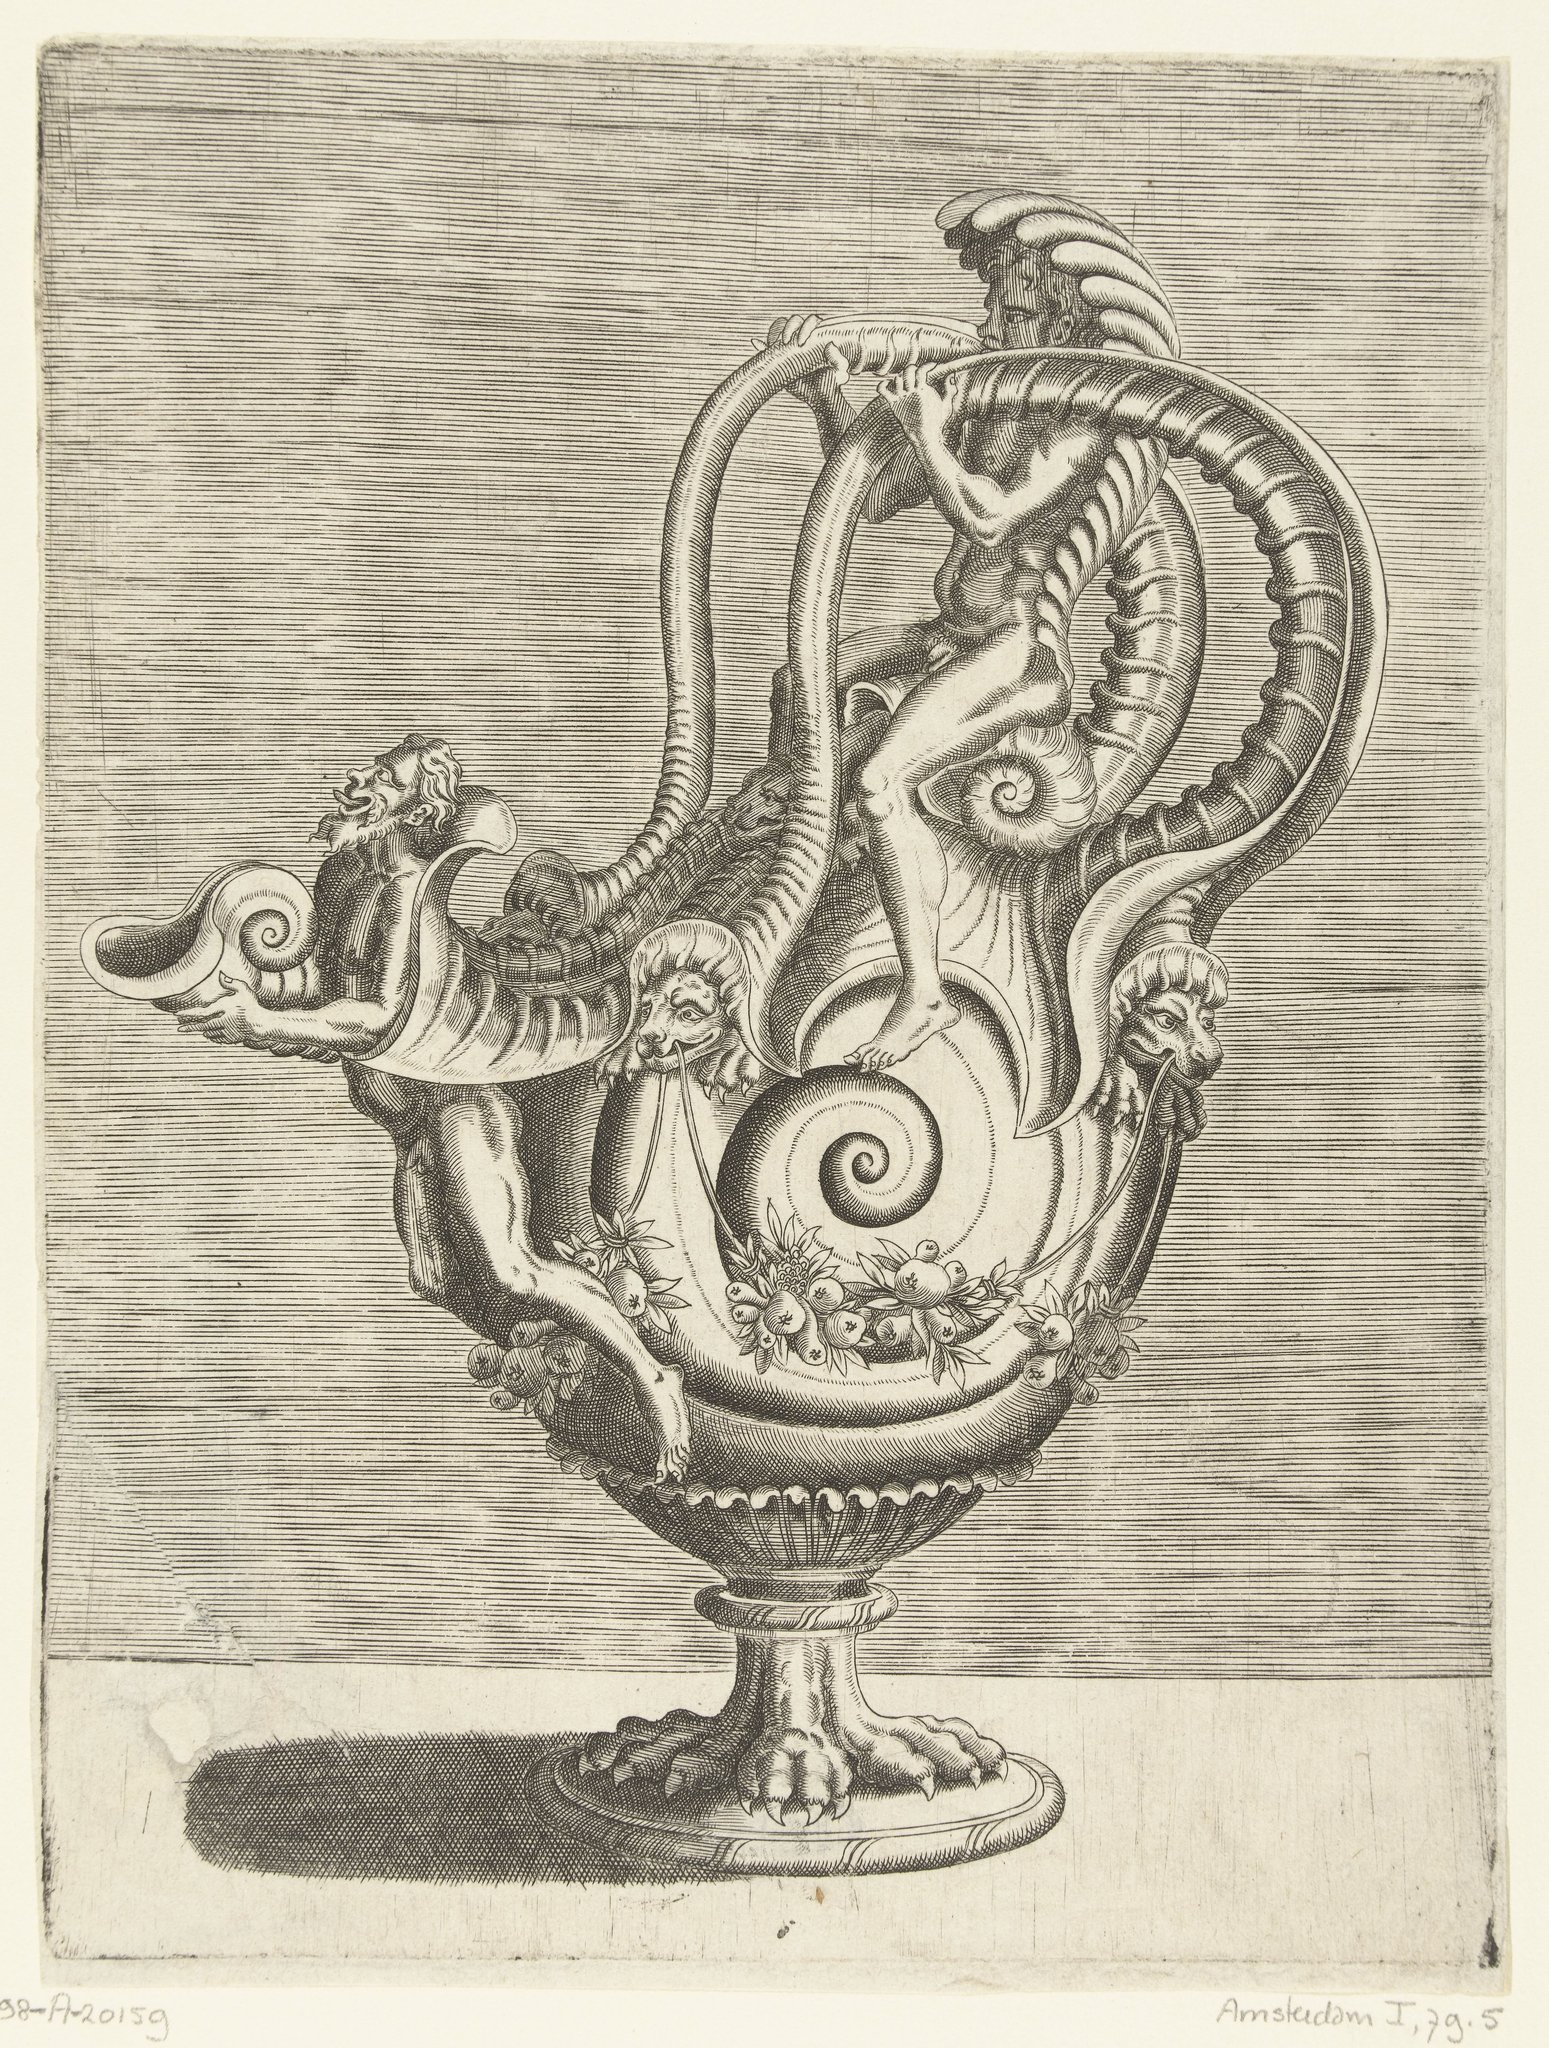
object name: ornament print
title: Vazen, kannen en schalen met grotesken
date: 1548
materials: paper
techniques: engraving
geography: netherlands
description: In het dubbele oor zit een man die met zijn handen het oor ondersteunt. De tuit bestaat uit een hoorn, vastgehouden door een man die tegen de buik van de kan hangt. Afkomstig uit een serie bestaande uit een titelblad en 20 bladen.